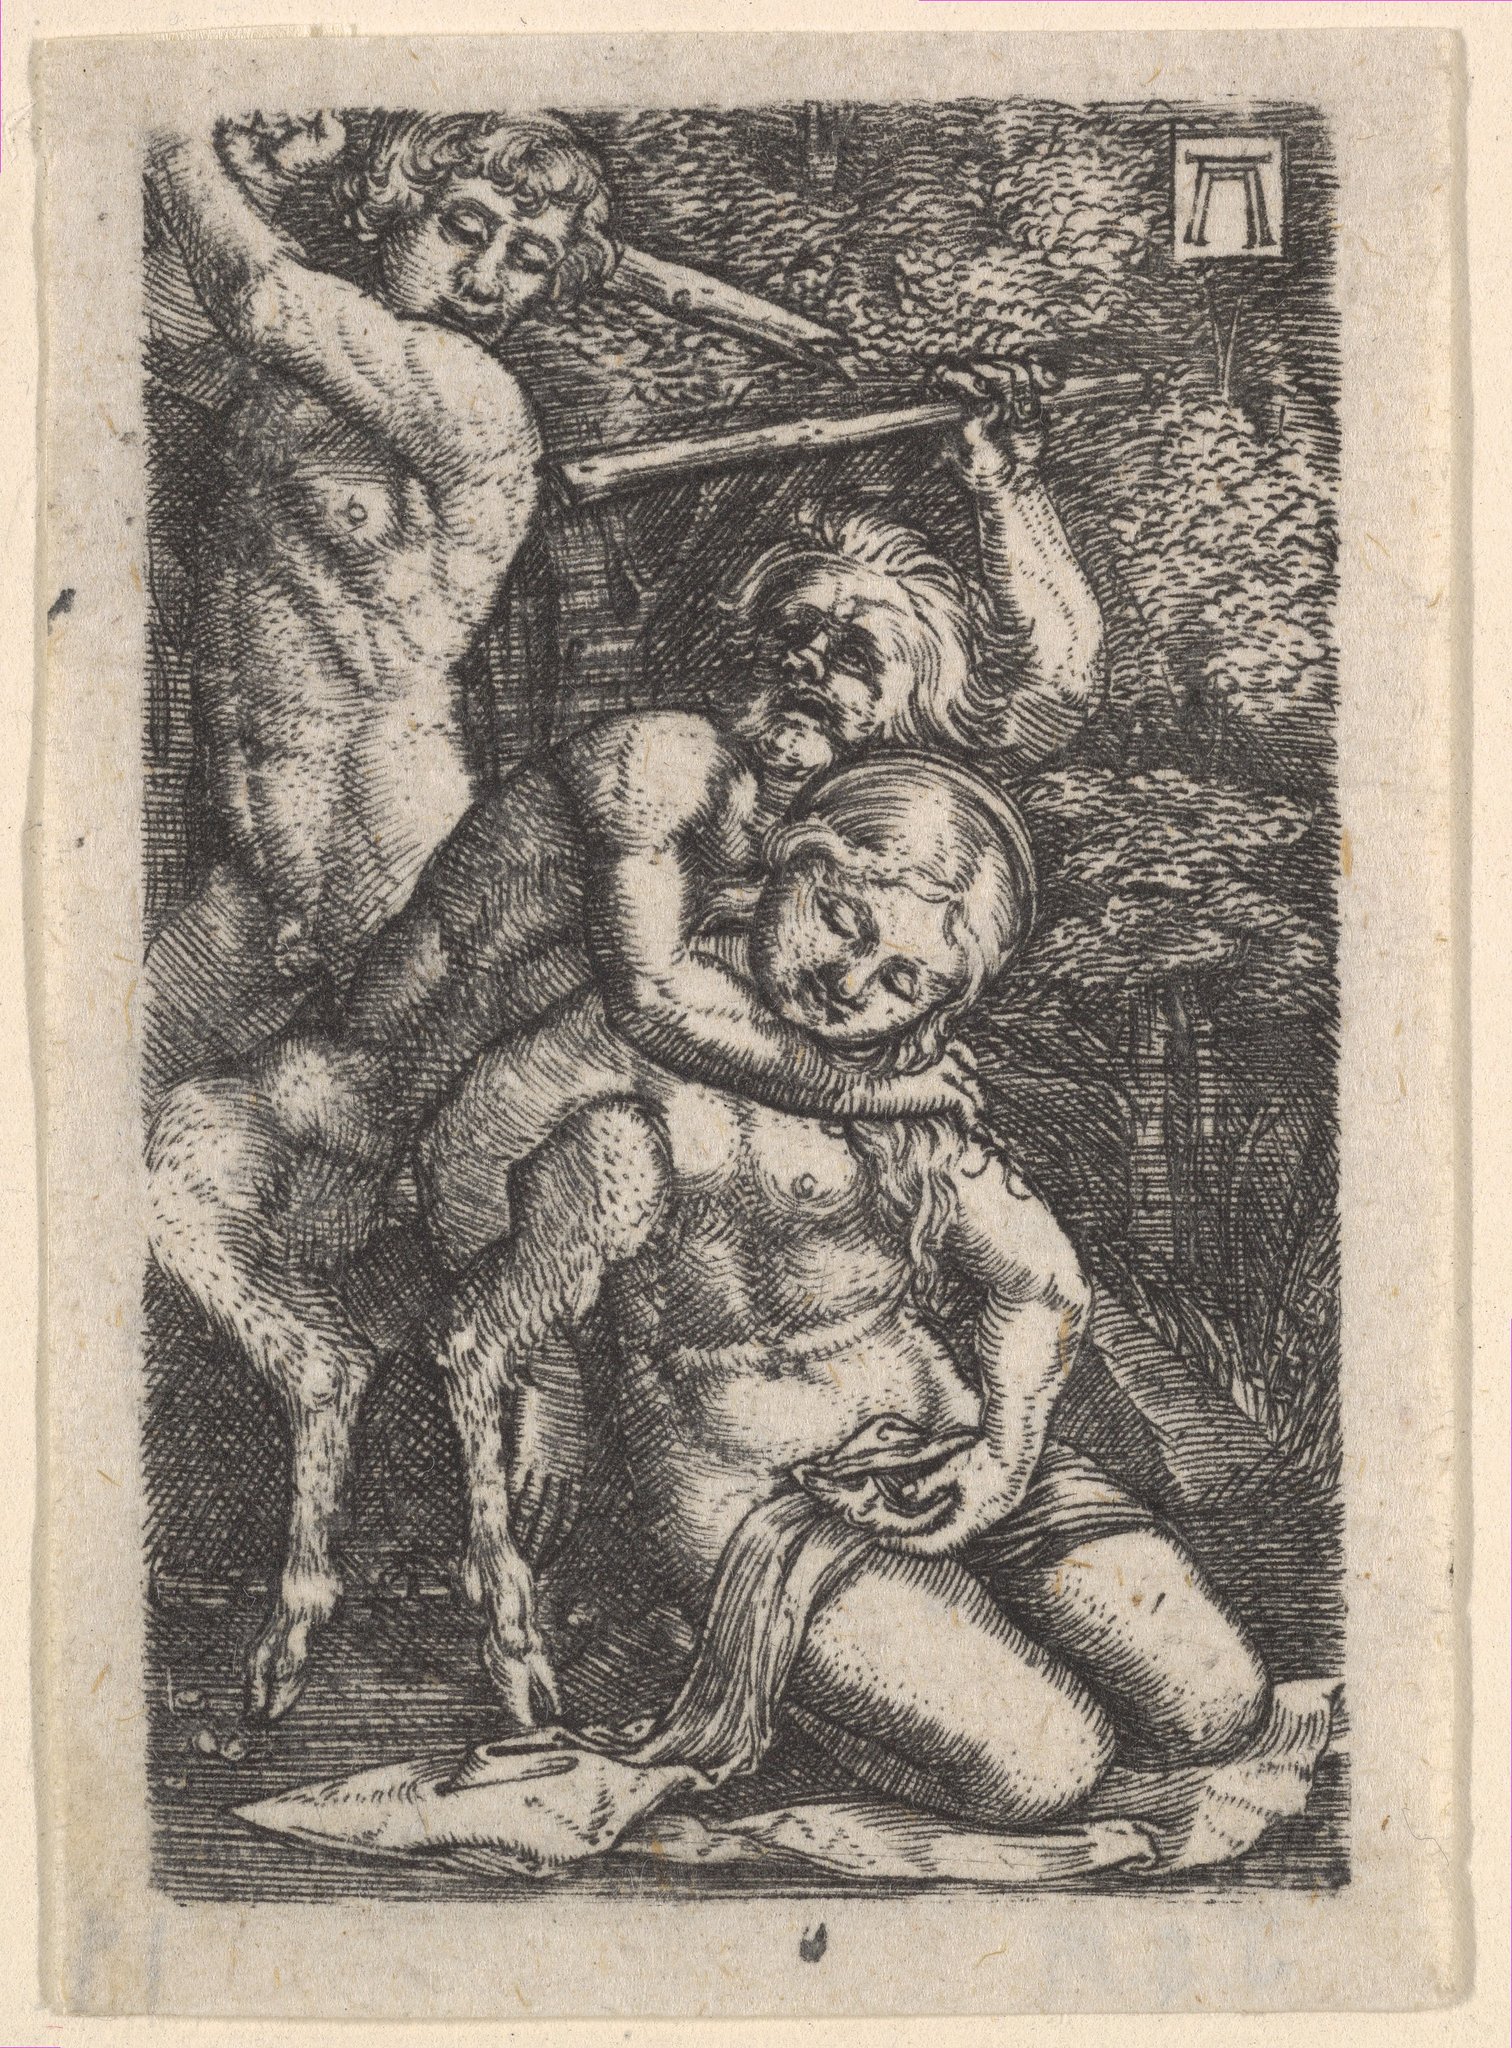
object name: print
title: Two Satyrs Fighting Over a Nymph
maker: albrecht altdorfer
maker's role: artist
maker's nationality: german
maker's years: 1480-1538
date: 1500-1538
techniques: engraving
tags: nymphs,satyrs